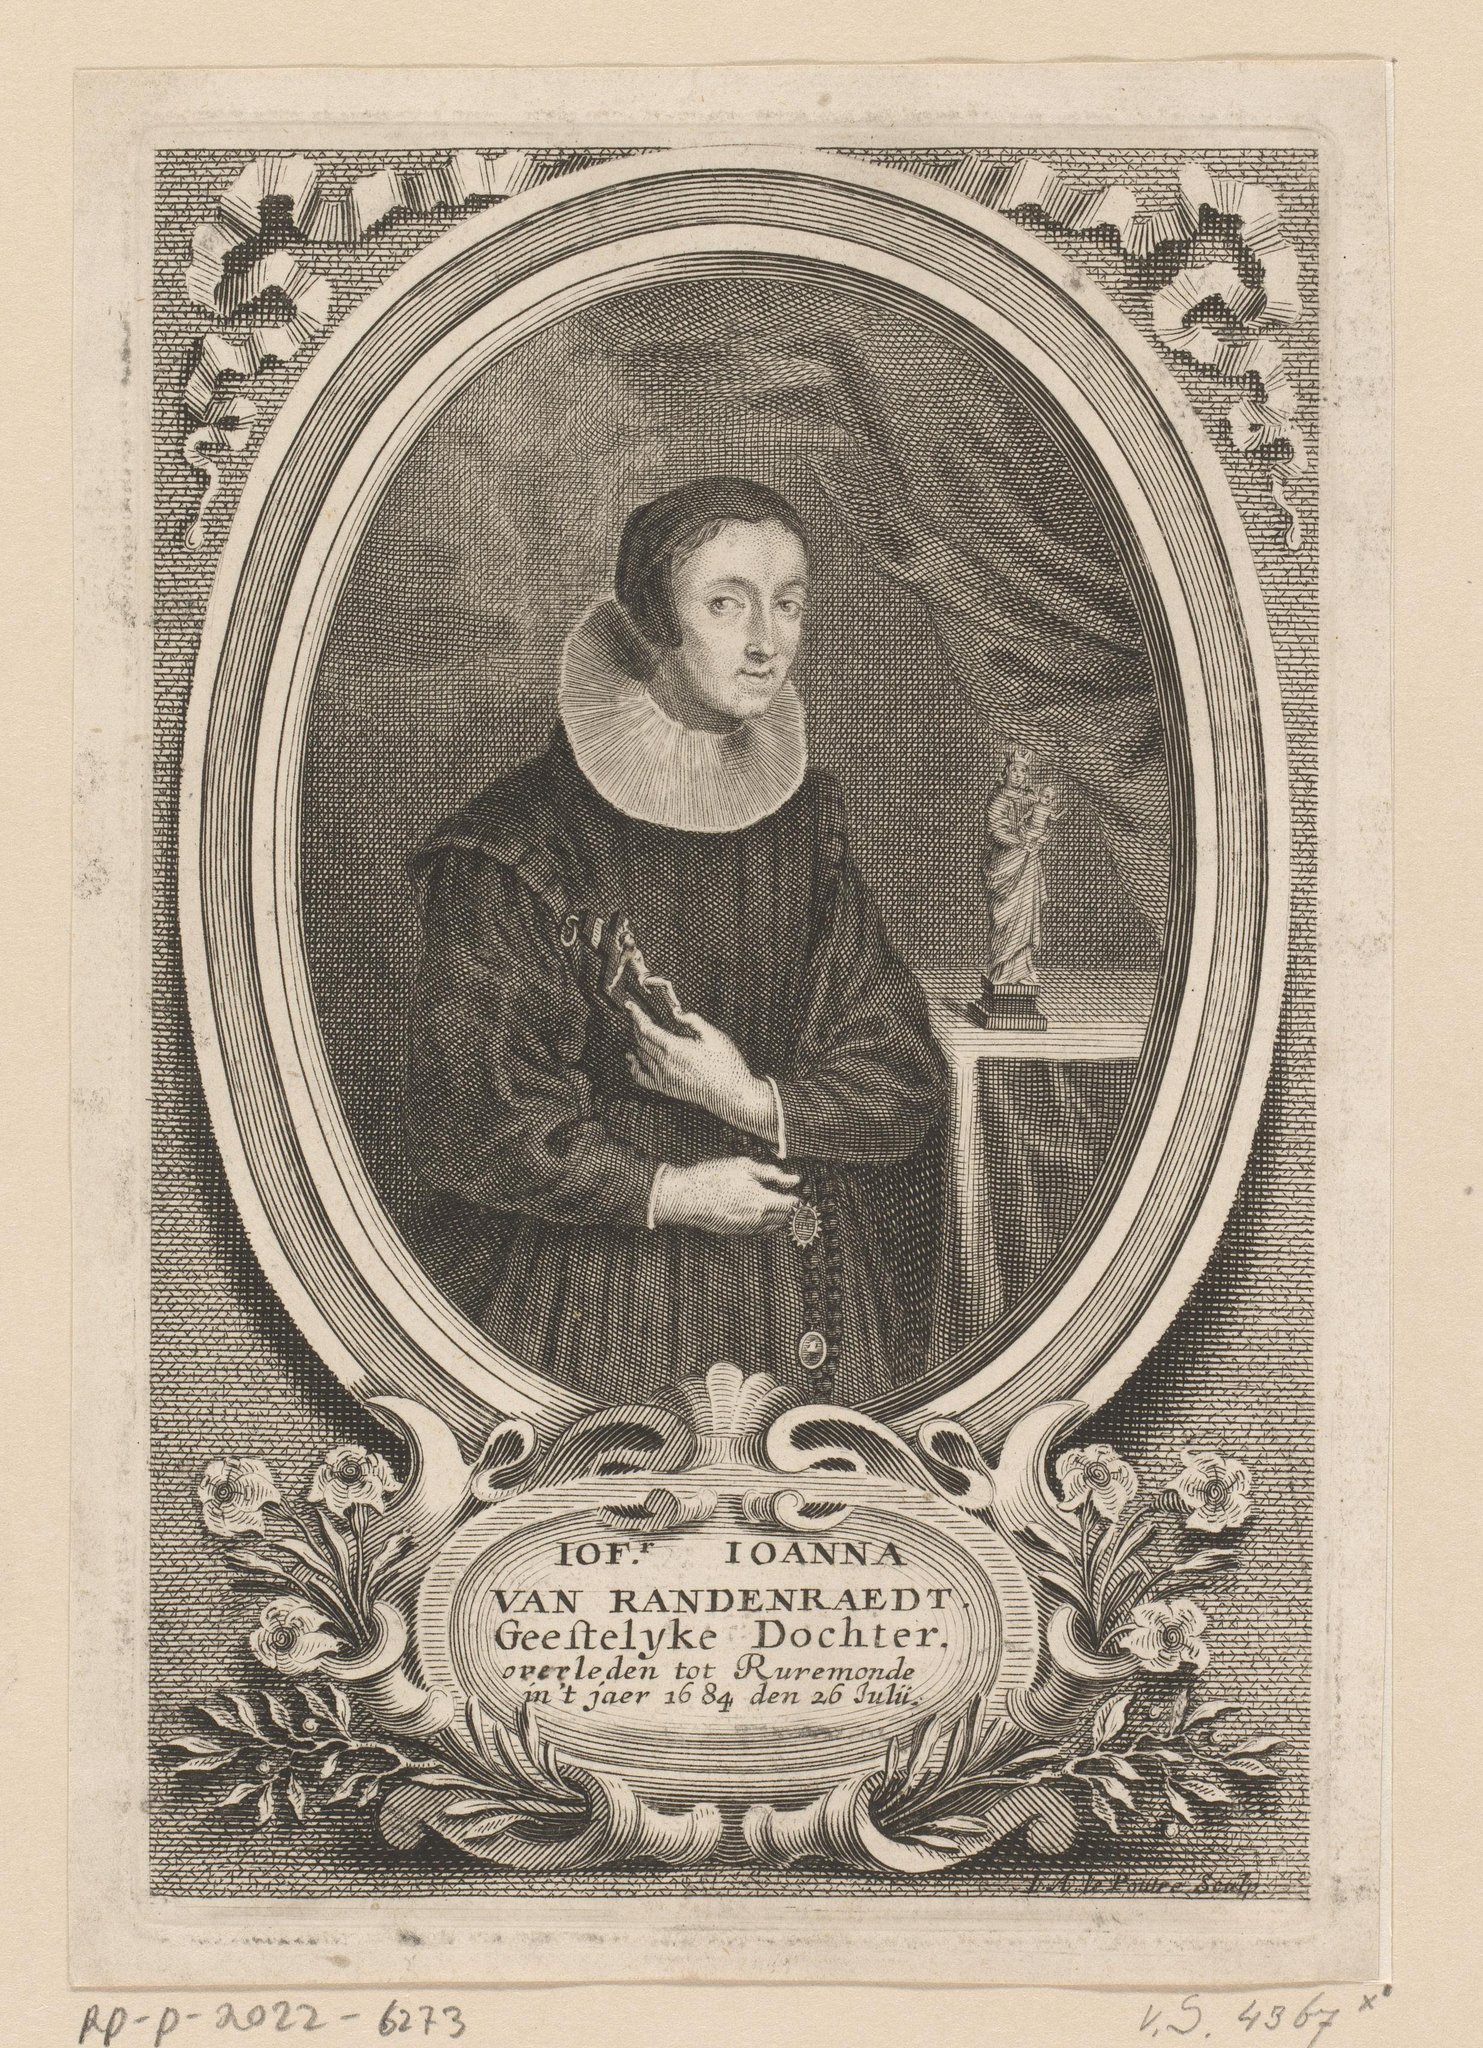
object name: print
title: Portret van Joanna Baptista van Randenraedt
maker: jean a. le poutre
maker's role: print maker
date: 1690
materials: paper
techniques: engraving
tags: brussels, clergyman, madonna: mary standing (or half-length), christ-child close to her bosom, historical persons - bb - woman, ornament ~ medallion, crucifix ~ personal devotion, ornament ~ cartouche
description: Prent waarschijnlijk uit: Huysmans, Daniel. Kort Begryp des levens ende der deughden vande weerdighe Joanna van Randenraedt (...). Antwerpen: Augustinus Graet, 1690.